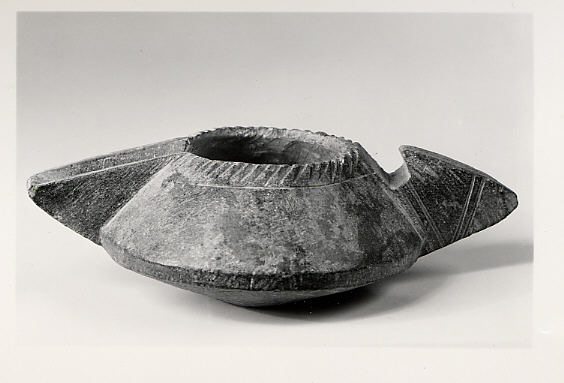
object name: lamp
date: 801-1100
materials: stone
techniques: carving, incising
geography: iran